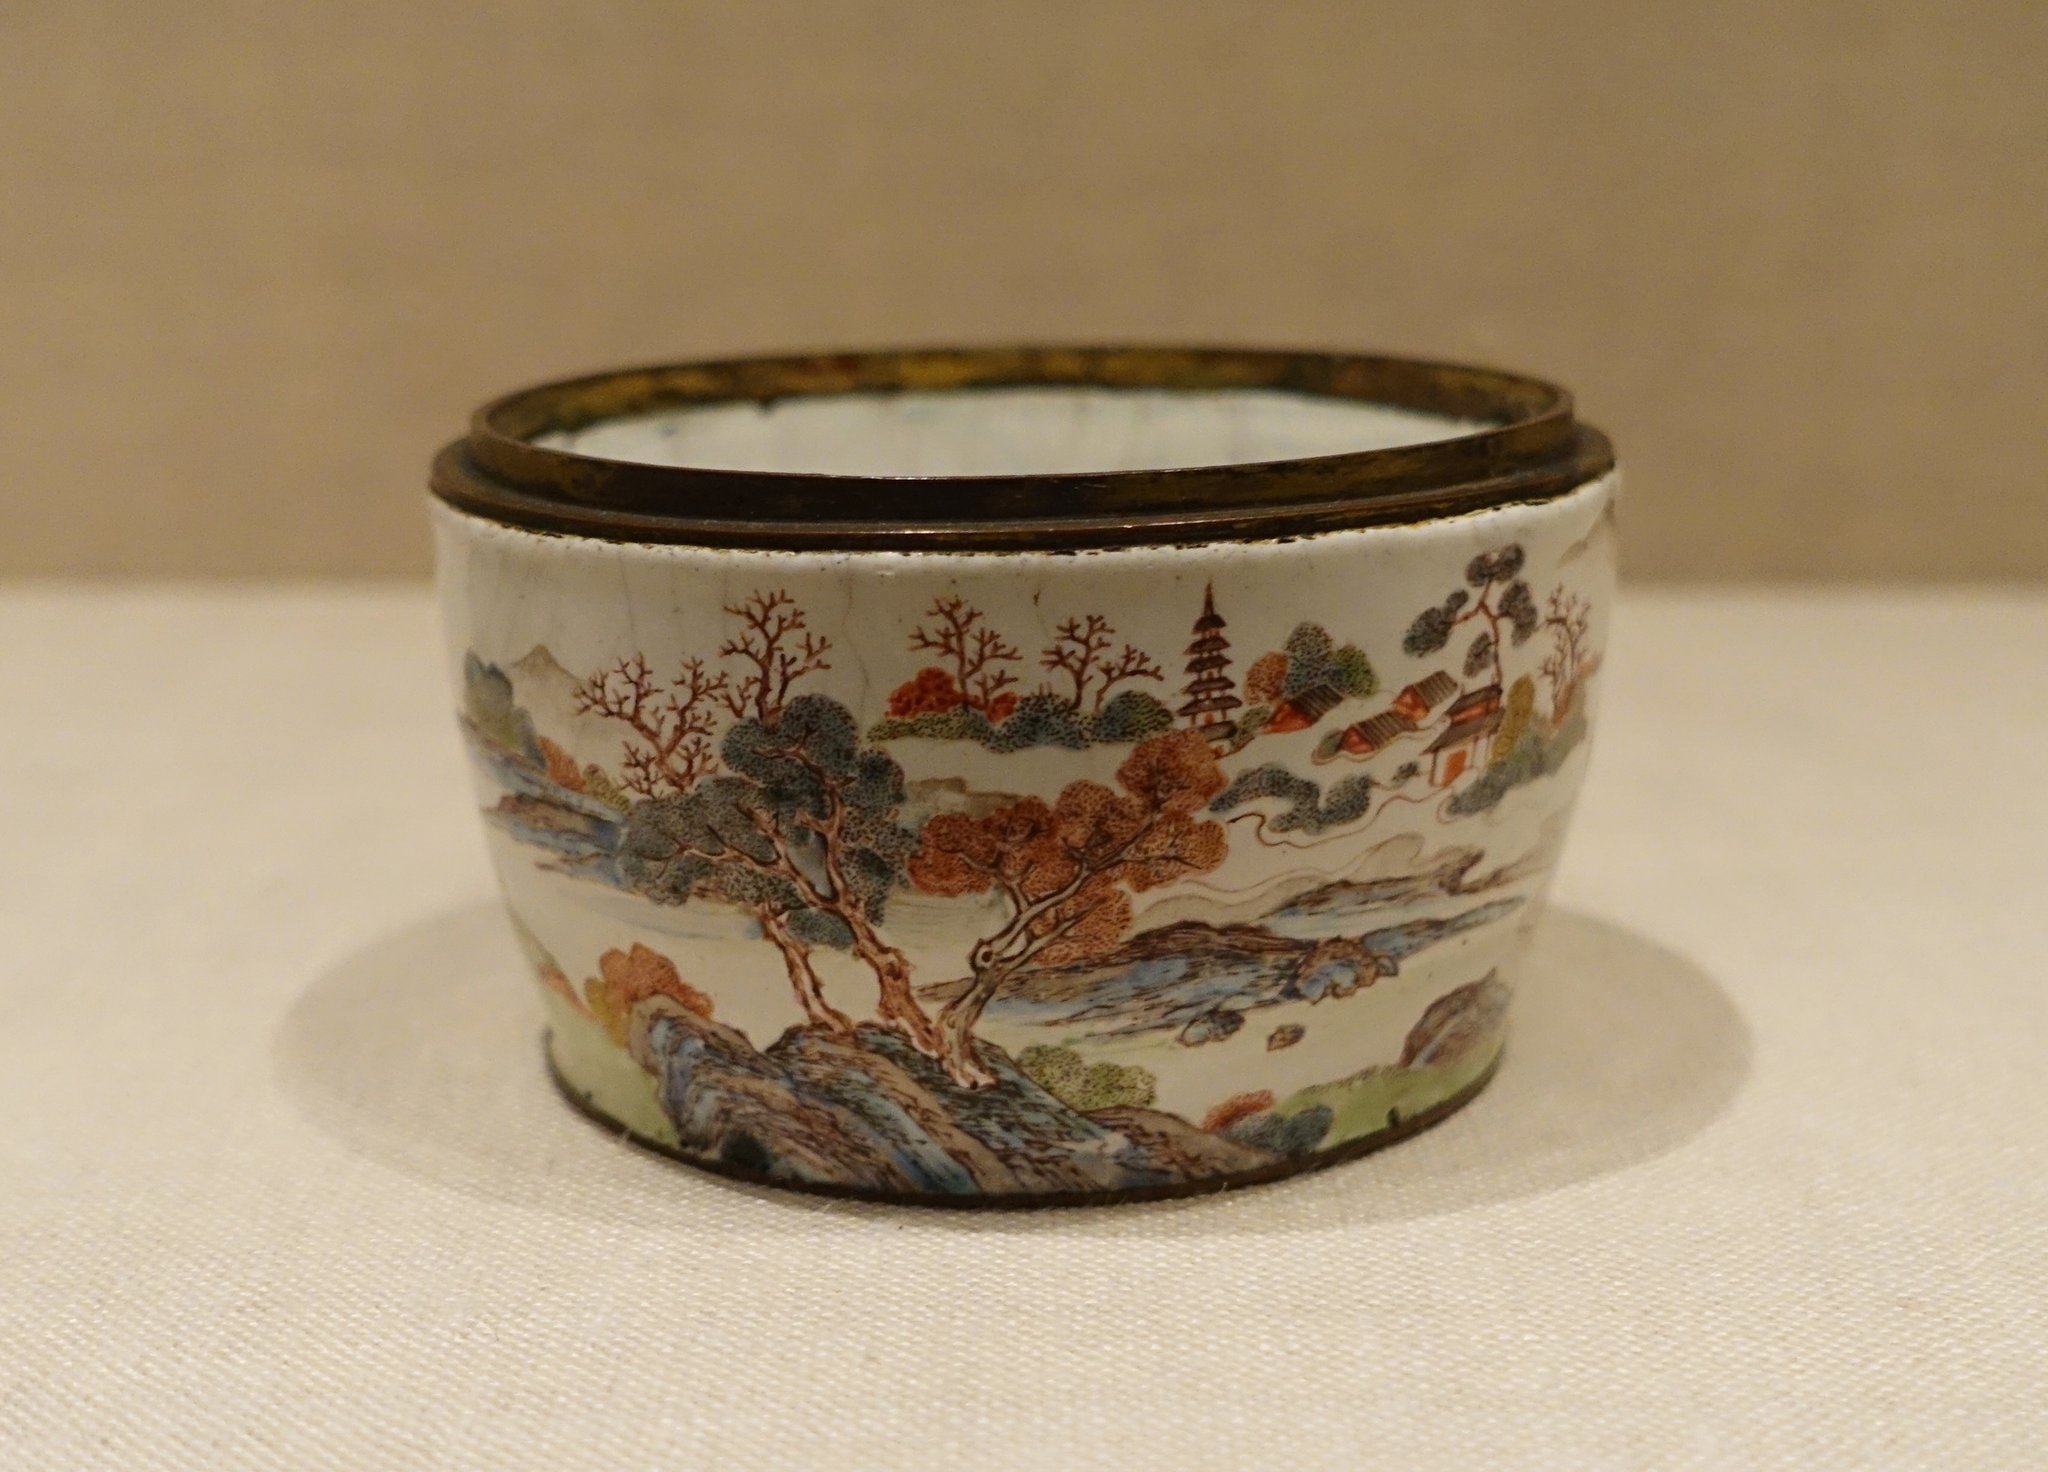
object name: box base one of a pair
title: Box base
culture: chinese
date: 1736-1795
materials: enamel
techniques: painting